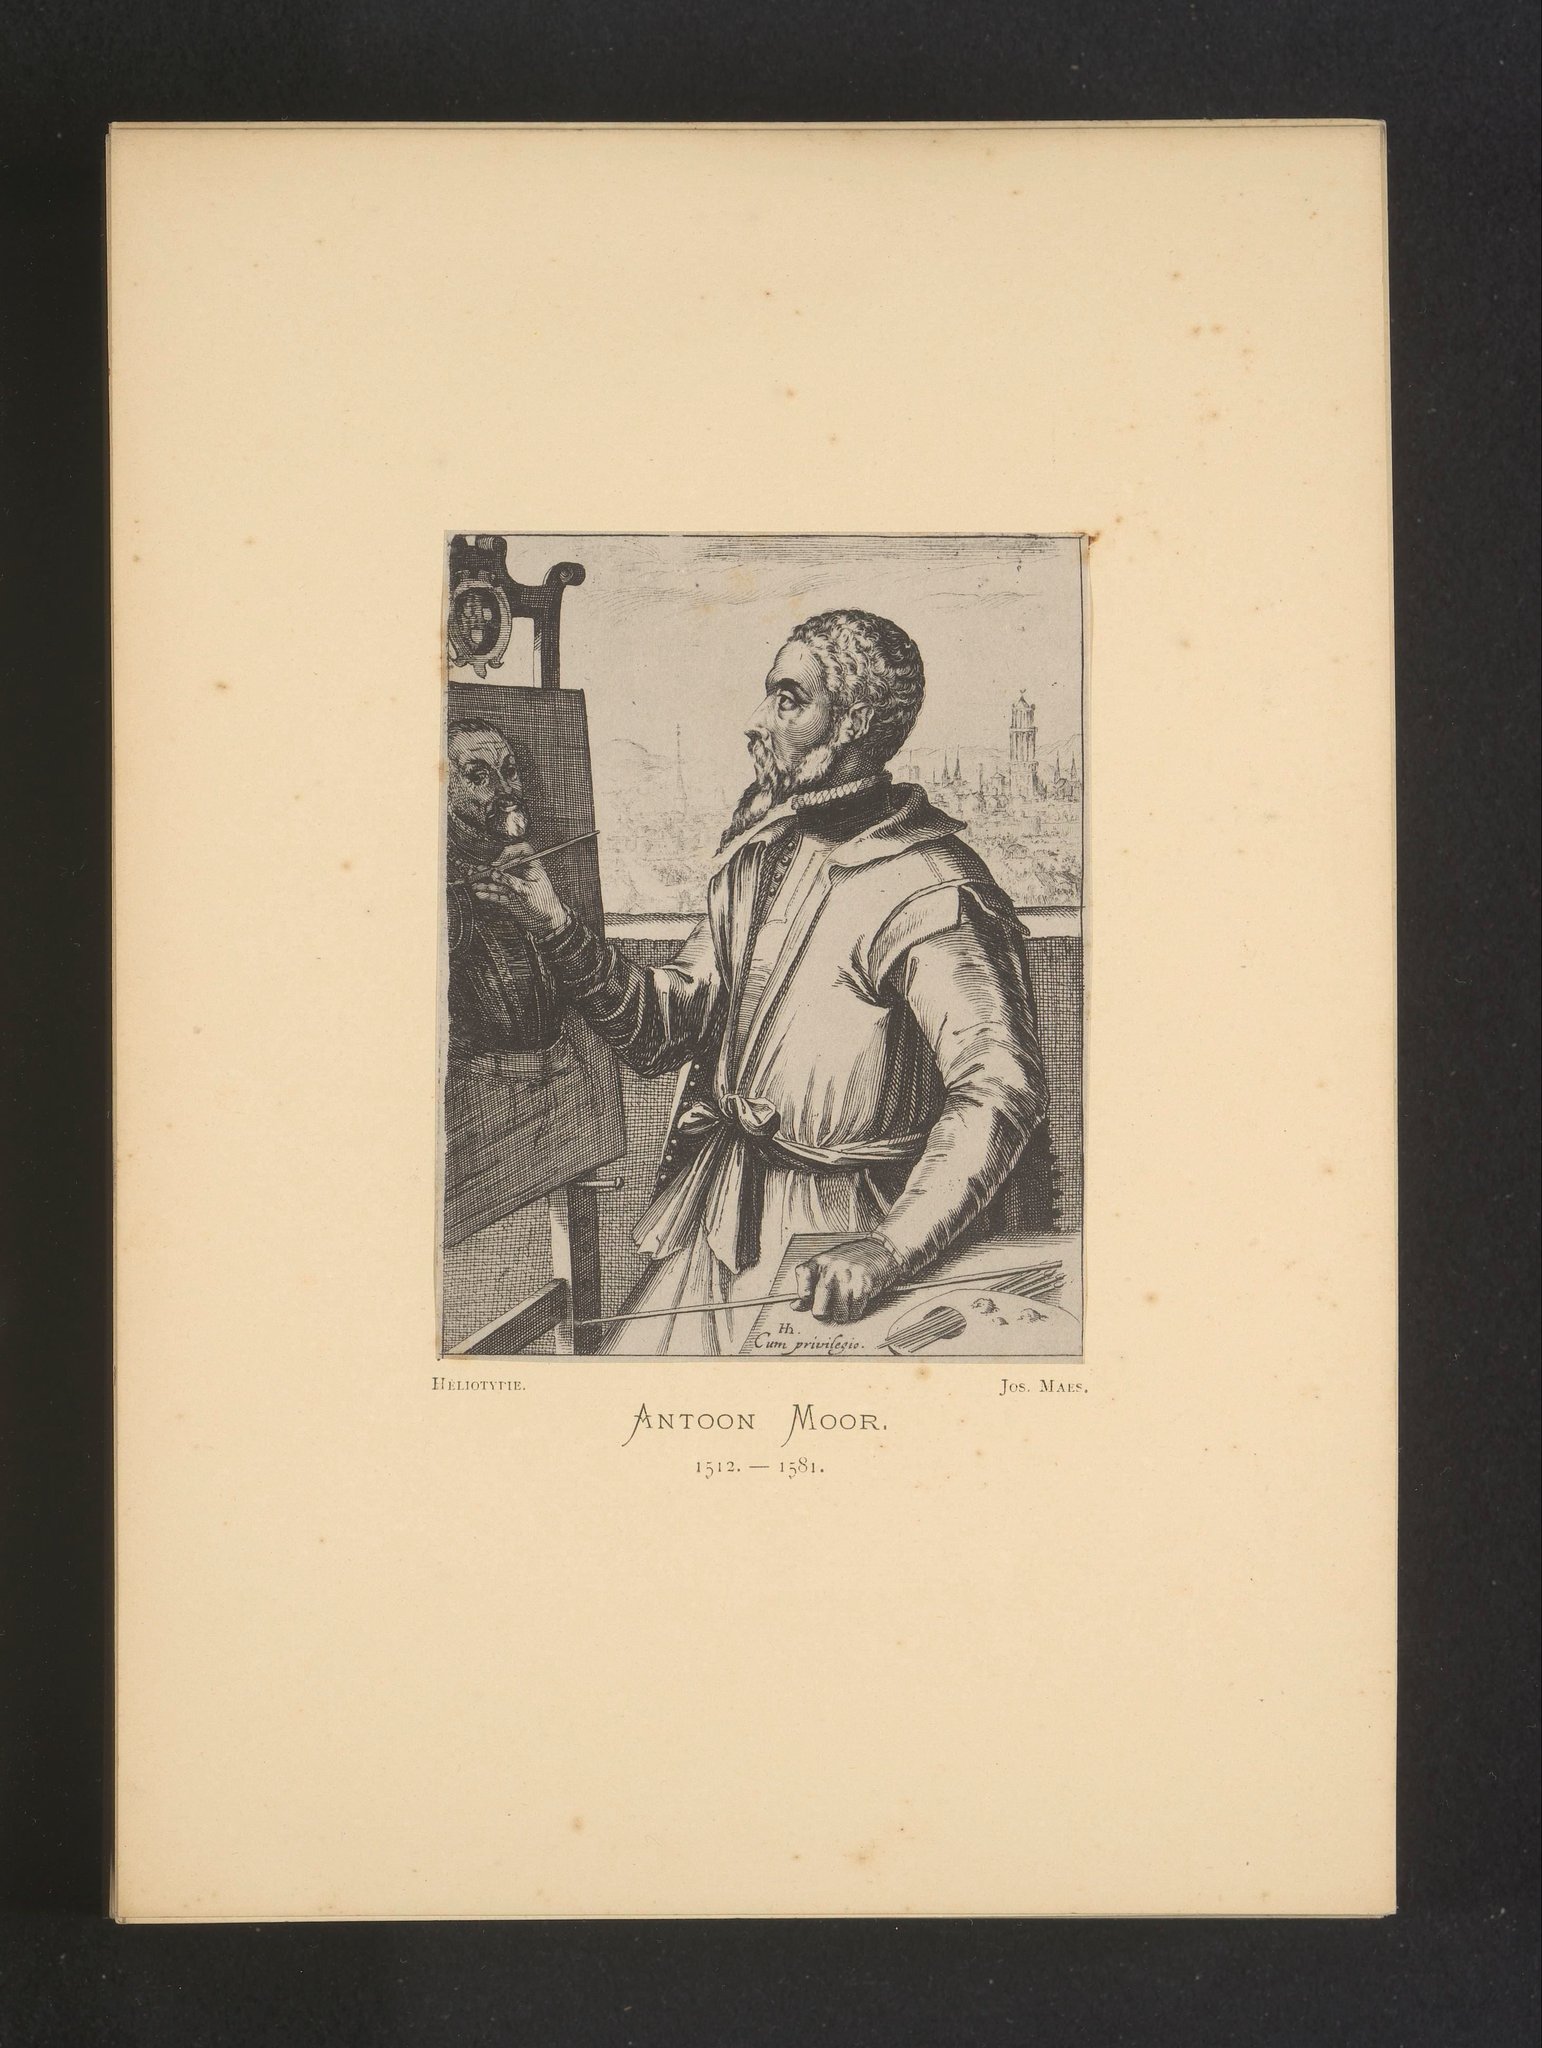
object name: photomechanical print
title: Reproductie van een gravure van een portret van Anthonis Mor door Hendrick Hondius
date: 1872-1877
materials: cardboard, paper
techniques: photograph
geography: antwerp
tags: utrecht, painter, draughtsman, anthonis mor, historical persons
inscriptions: inscription: ‘1512. - 1581.’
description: Deze prent maakt deel uit van een omslag met 150 prenten en een katern met een lijst van afbeeldingen.